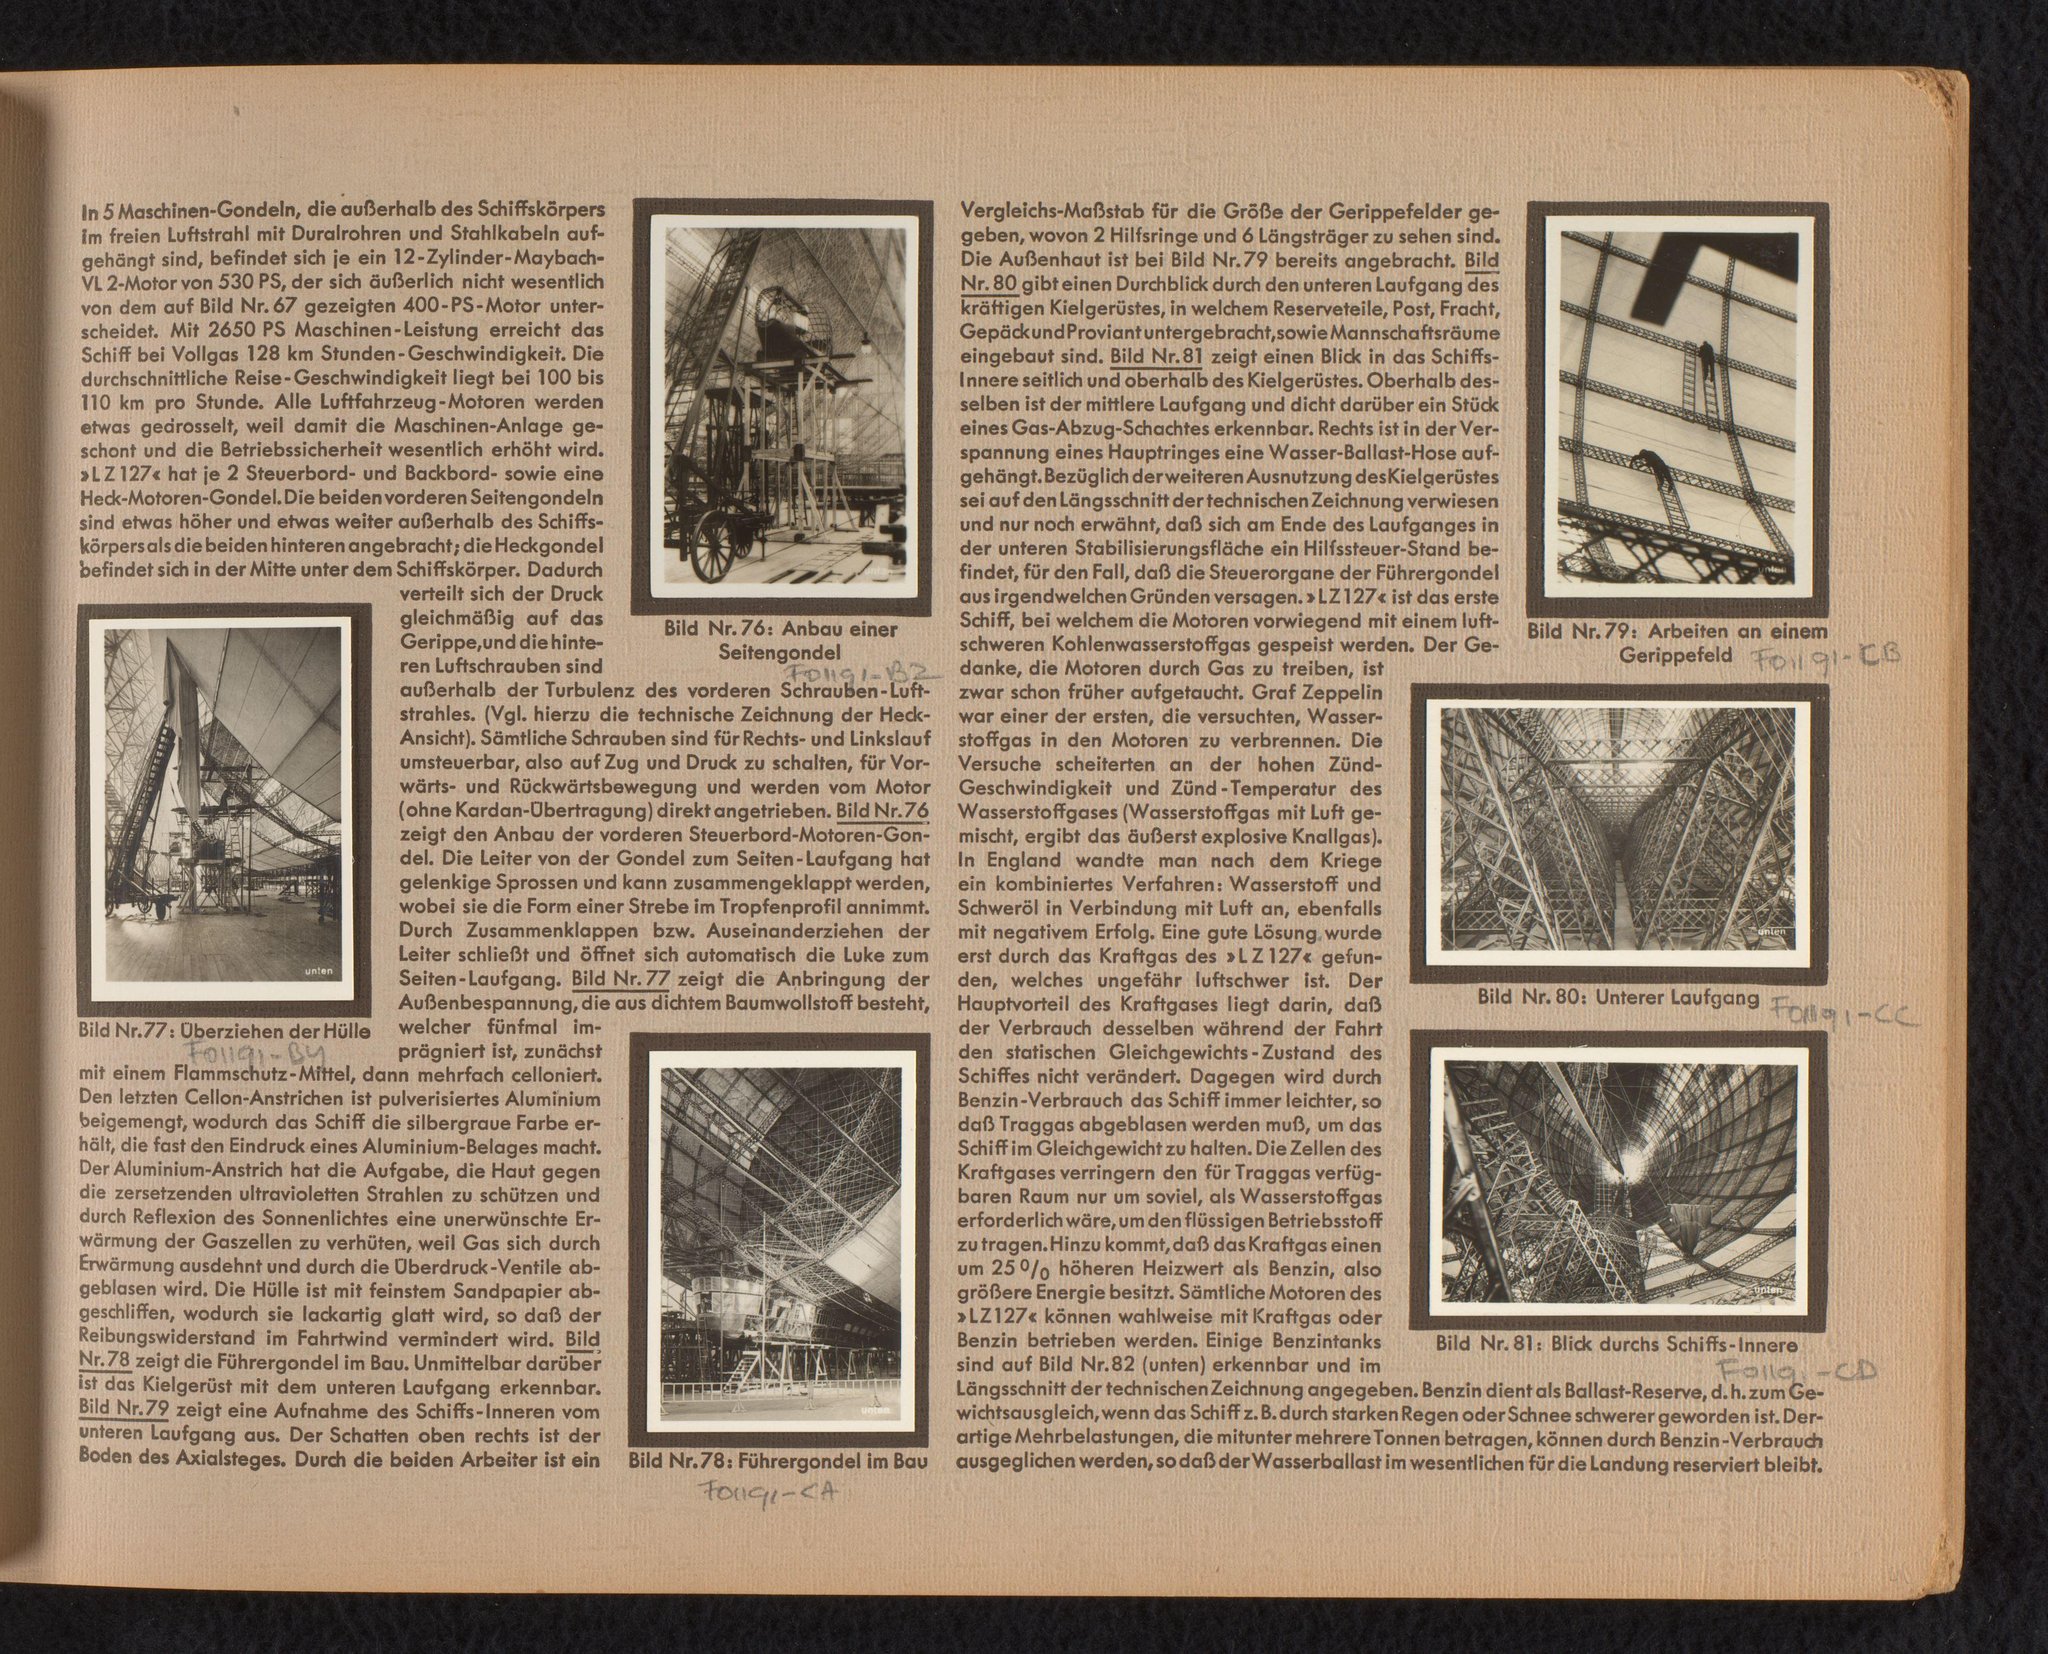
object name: album leaf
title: Bouw van een zeppelin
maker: Anonymous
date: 1905-1925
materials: paper, photographic support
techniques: gelatin silver print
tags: industrial structures, 46c35 airship, zeppelin, germany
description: Zes foto's van de bouw van een zeppelin. Alle foto's zijn voorzien van een nummer en titel. Deze pagina maakt deel uit van een album.